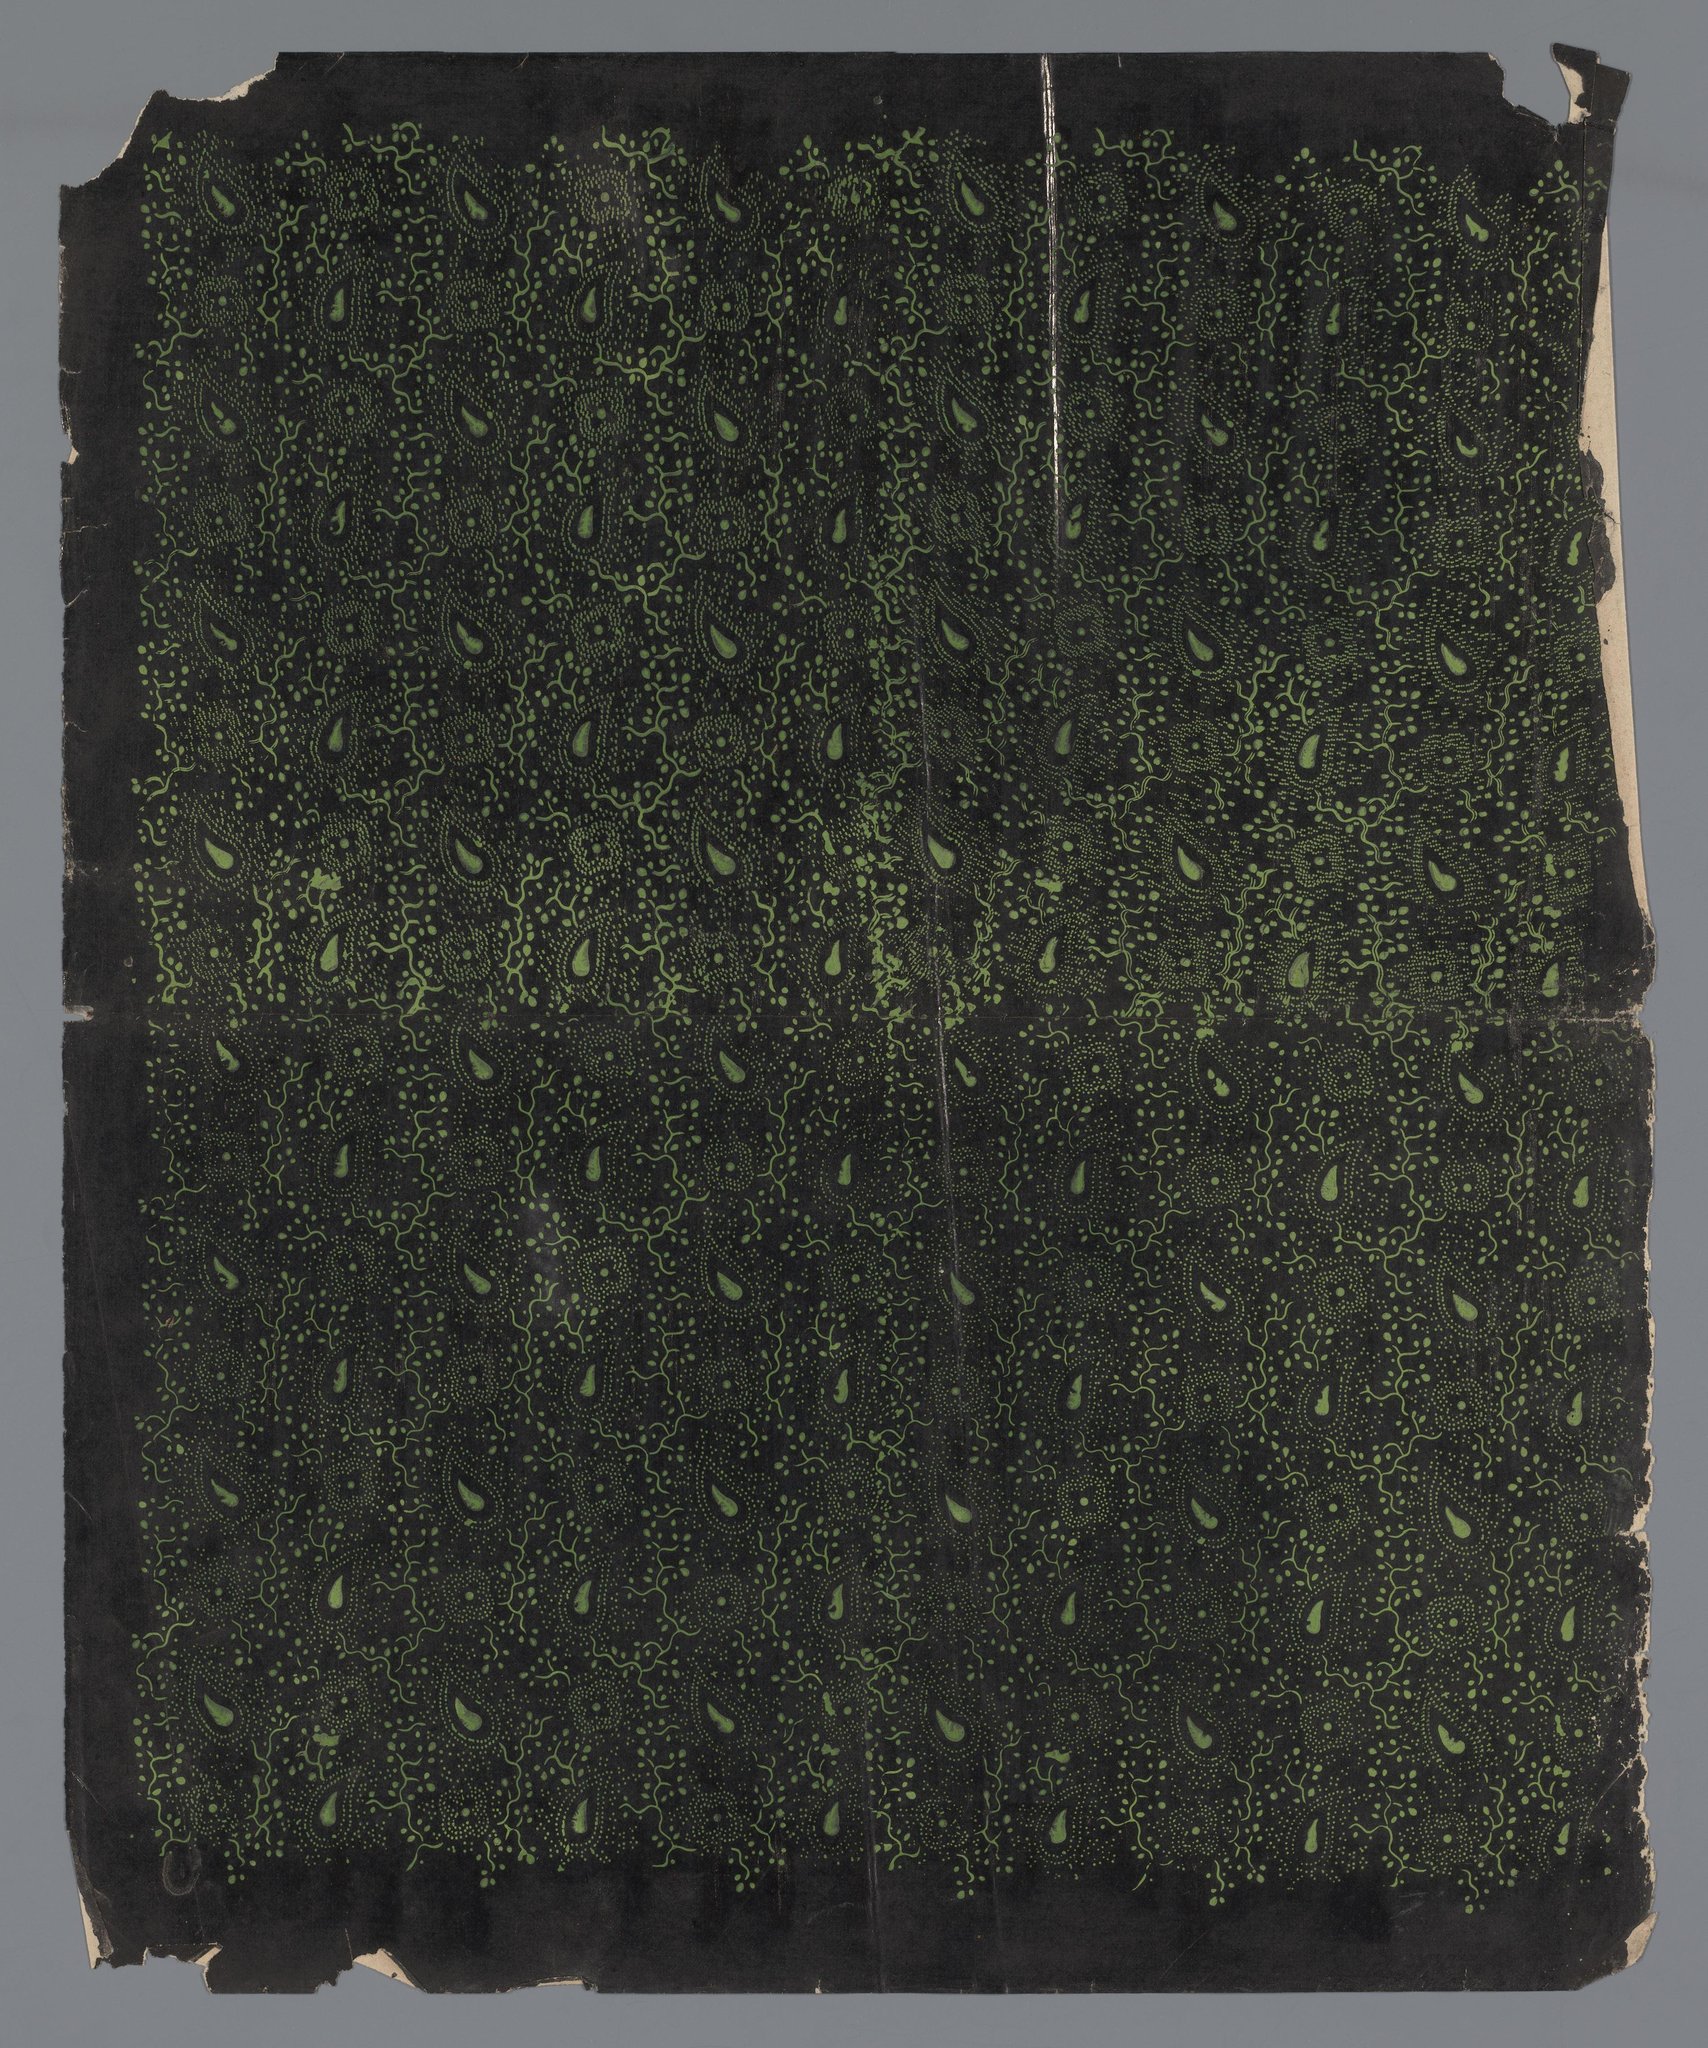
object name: printed paper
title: Blad met patroon van stippen en paisleymotief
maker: Anonymous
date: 1850-1950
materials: lacquer, paint, paper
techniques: printing block, lacquer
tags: fantasy ornament, ornament derived from plant forms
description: Blad met een rankenpatroon met paisleymotief tussen stippellijnen en punten.